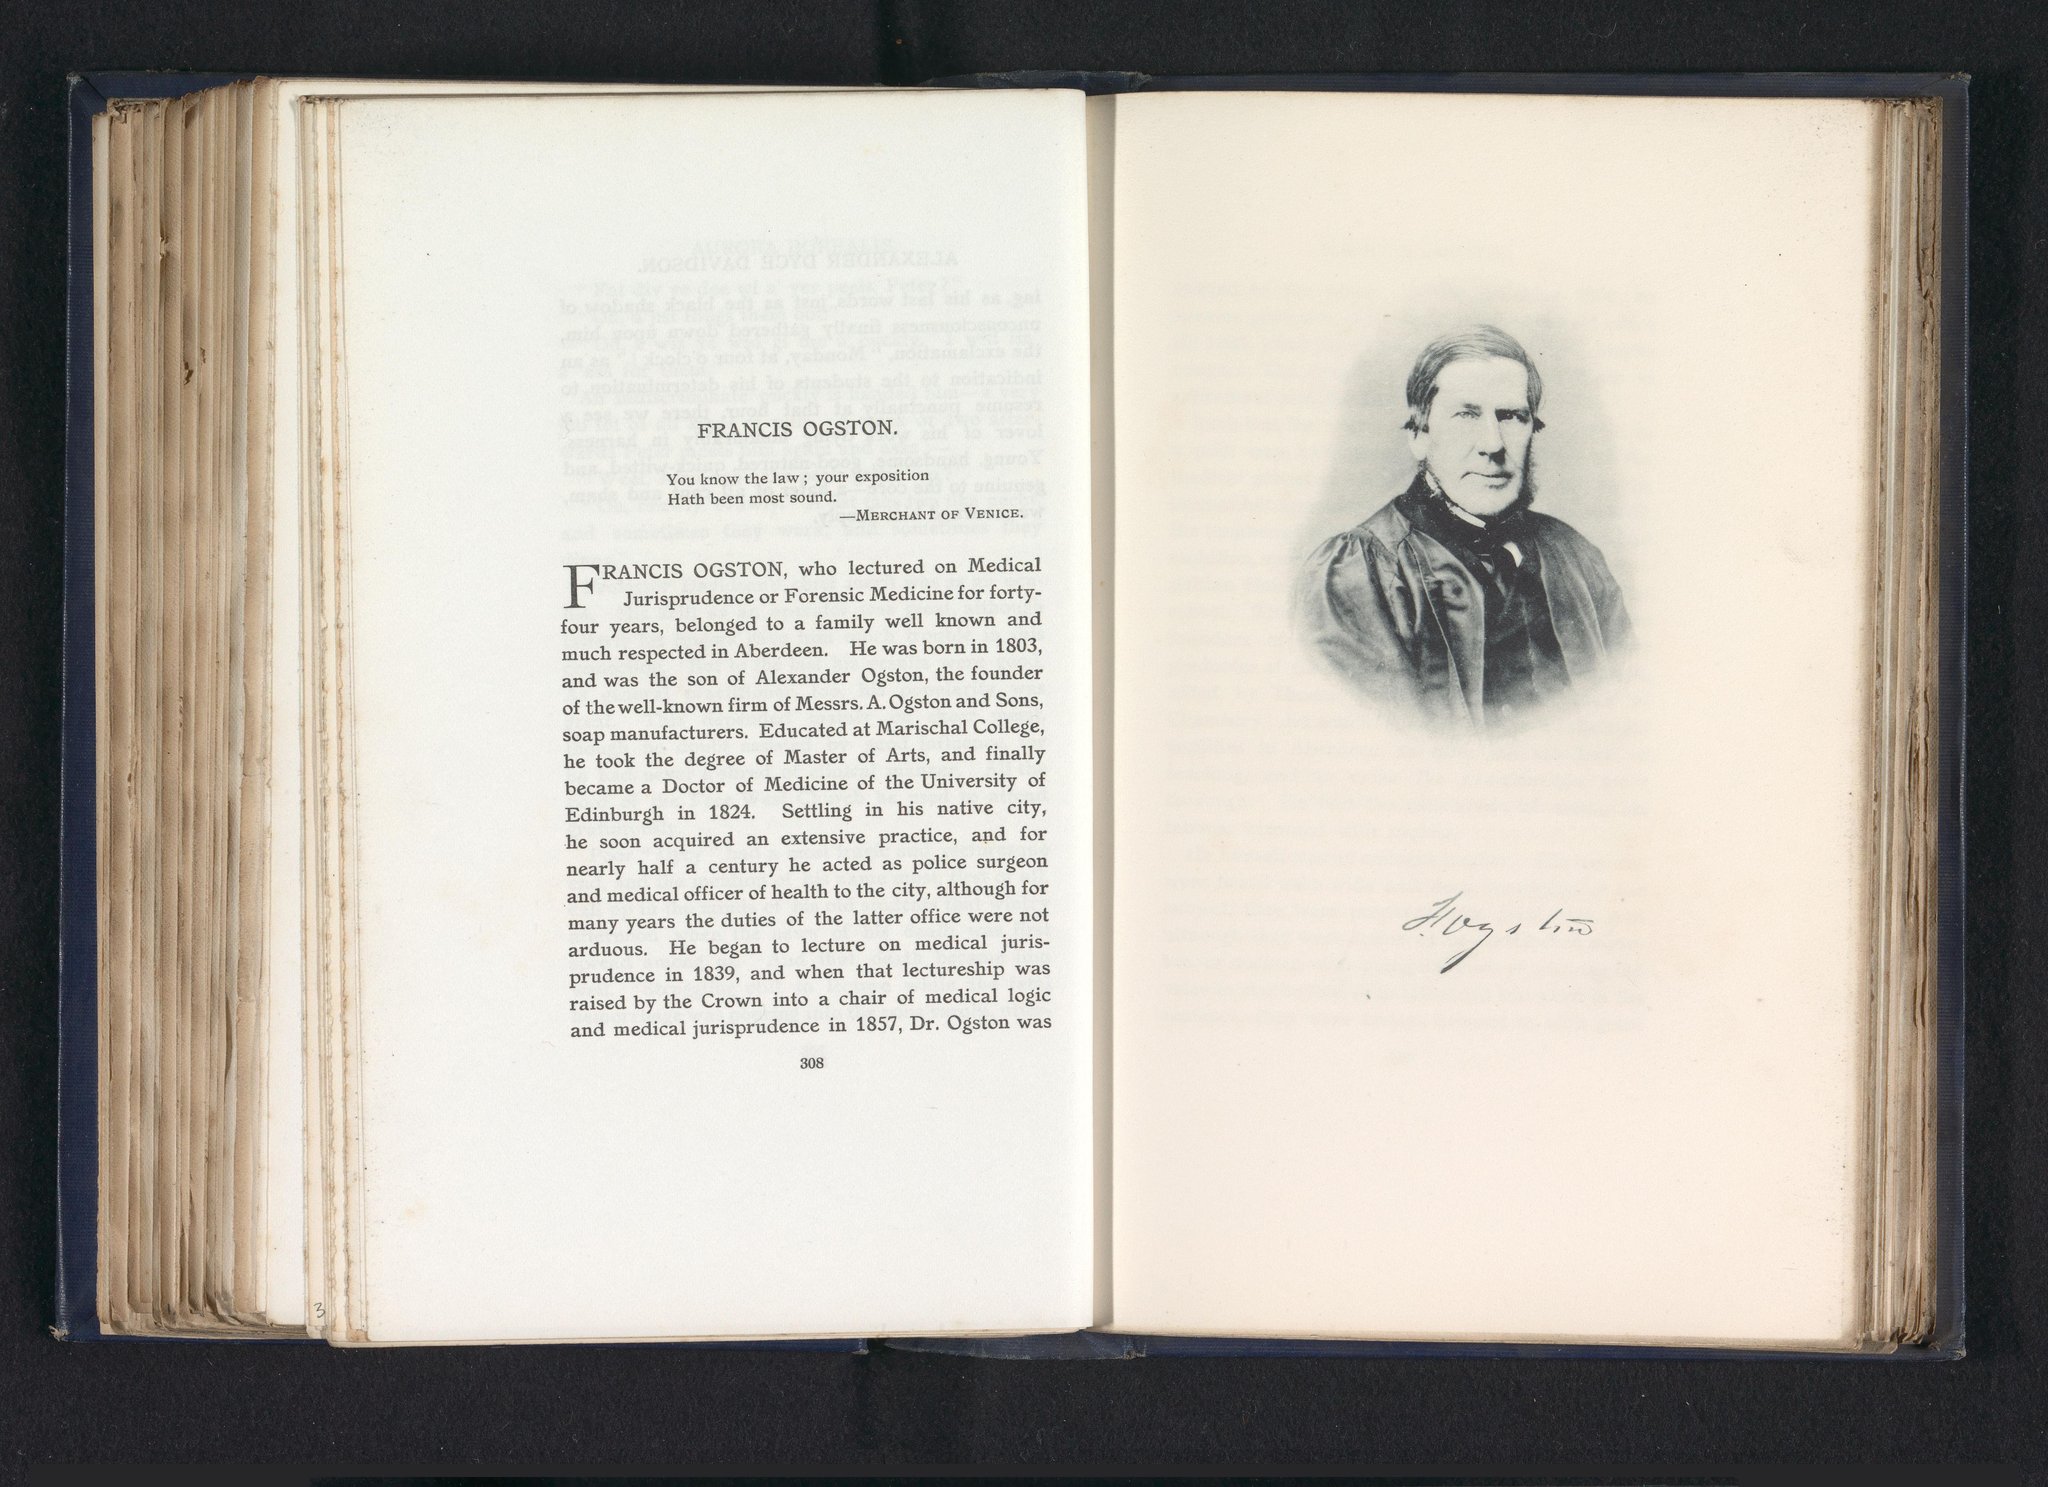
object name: page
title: F. Ogston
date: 1877-1887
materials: paper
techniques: photograph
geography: aberdeen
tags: scholar, philosopher